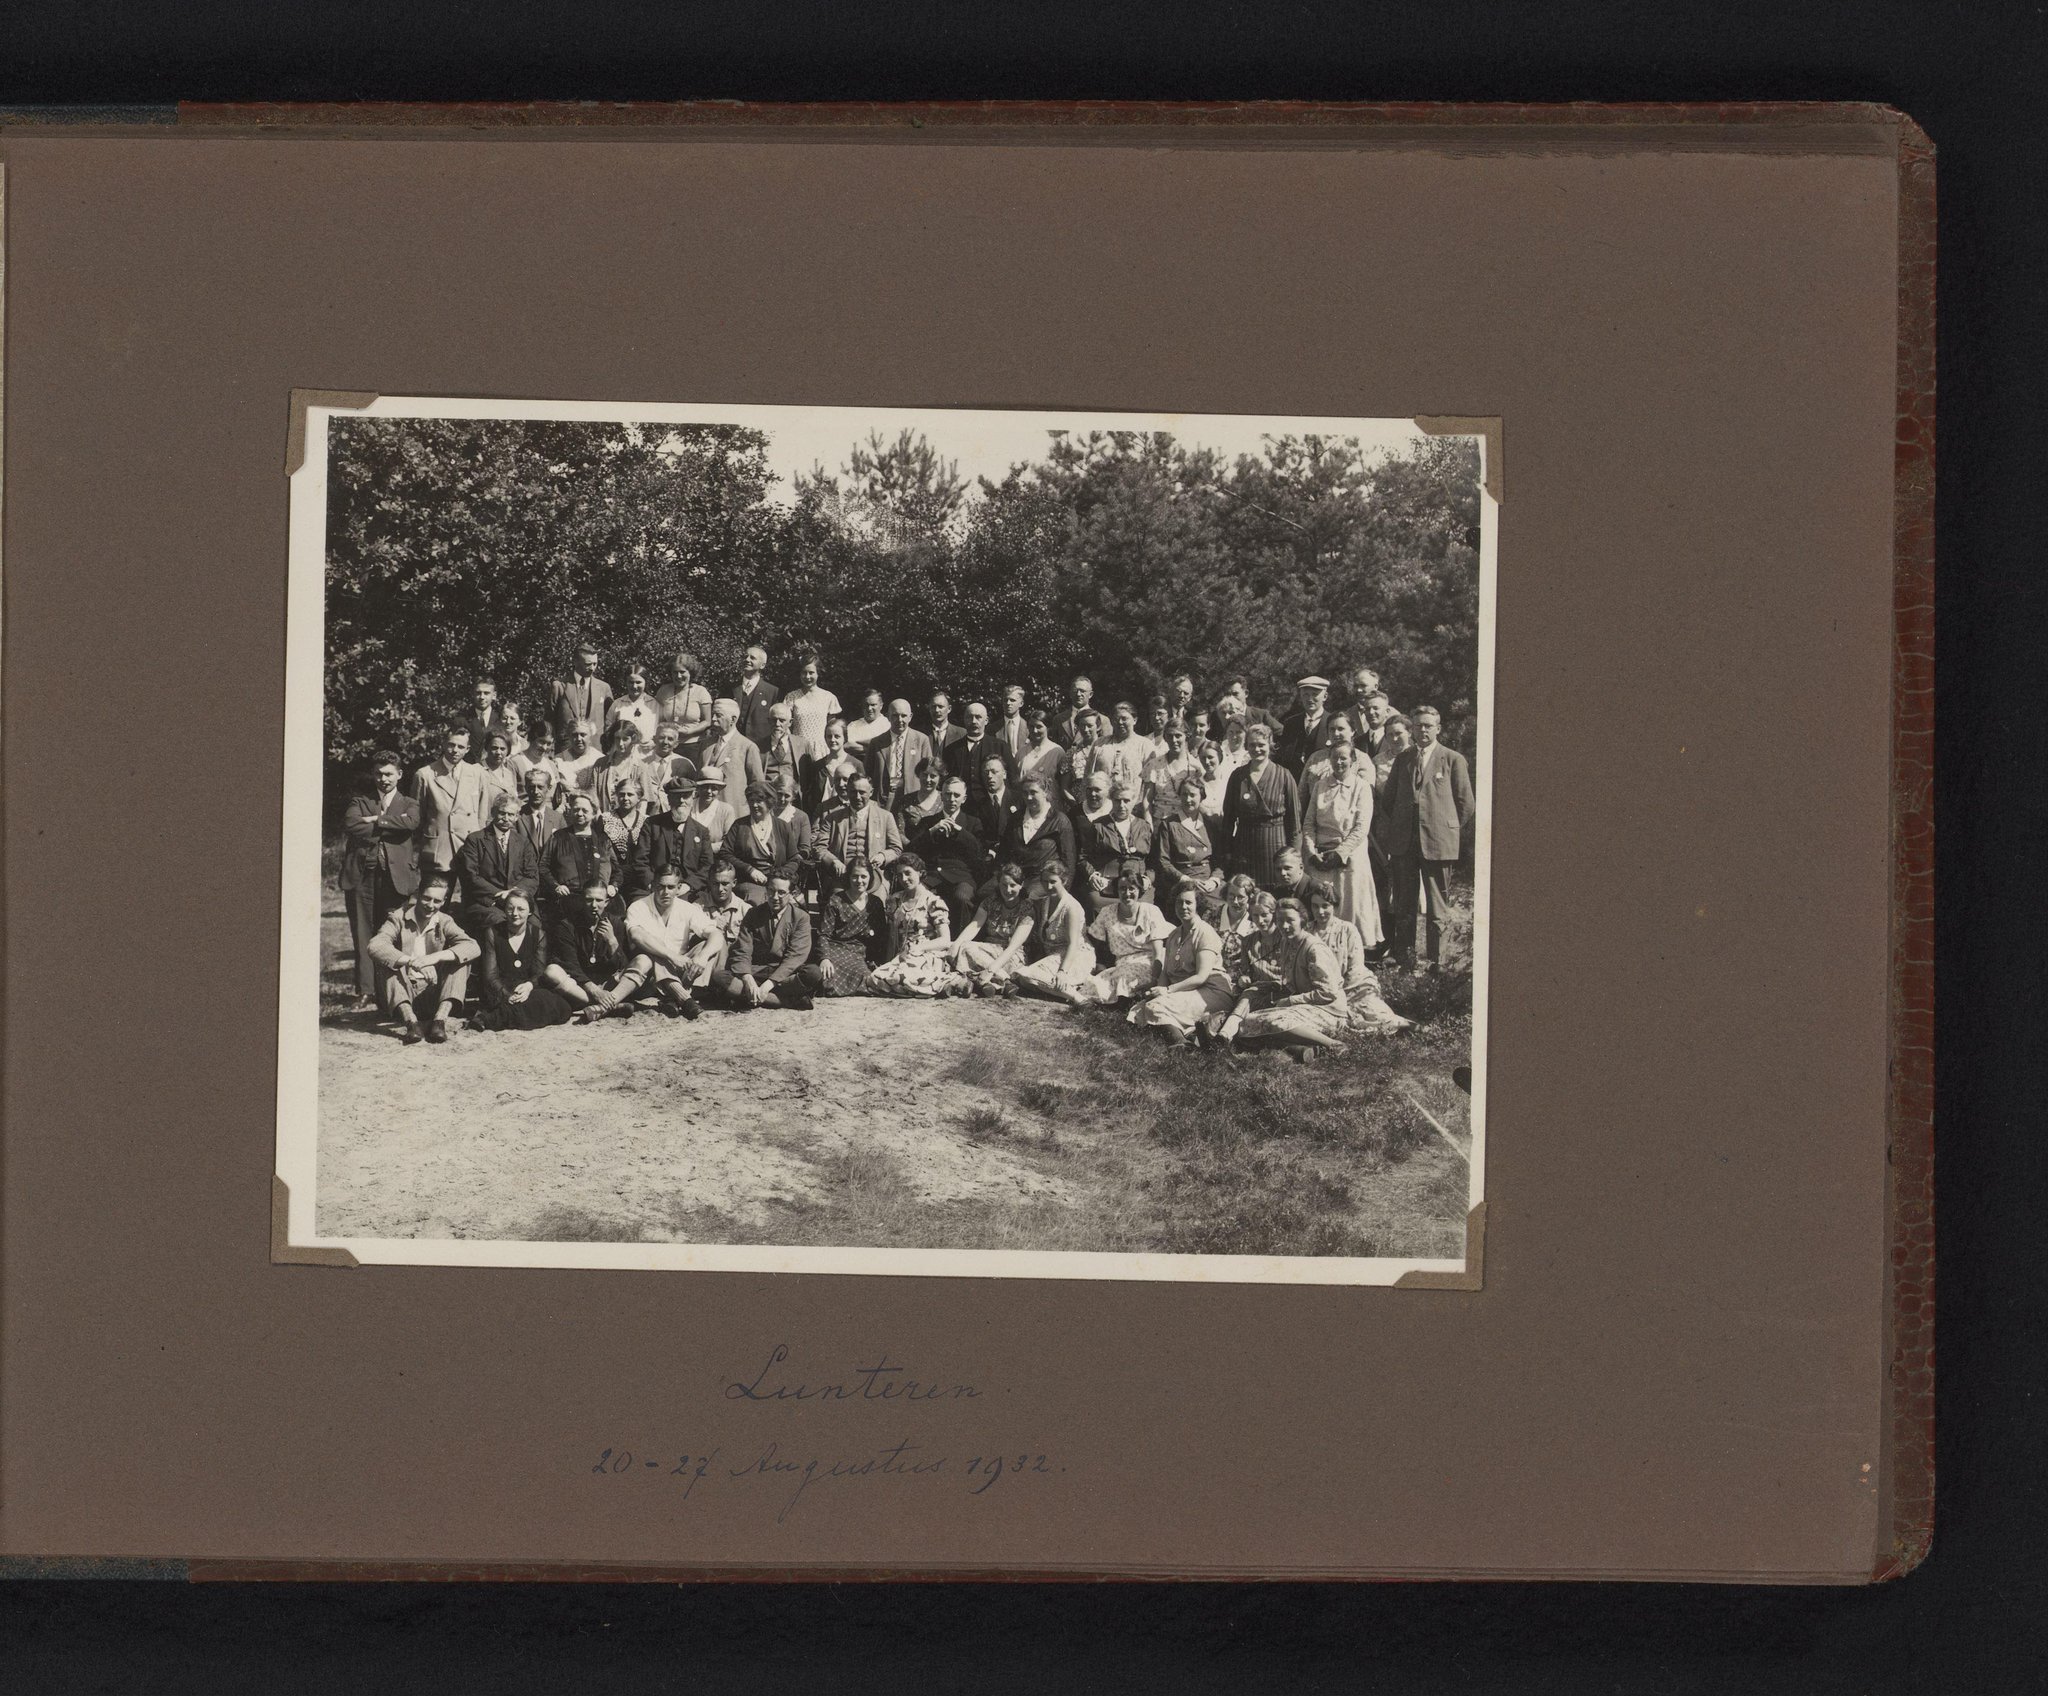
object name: photograph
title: Groepsportret te Lunteren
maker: Anonymous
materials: paper, photographic support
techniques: gelatin silver print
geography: lunteren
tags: anonymous historical persons portrayed in a group, in a group-portrait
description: Deze pagina maakt deel uit van een album.